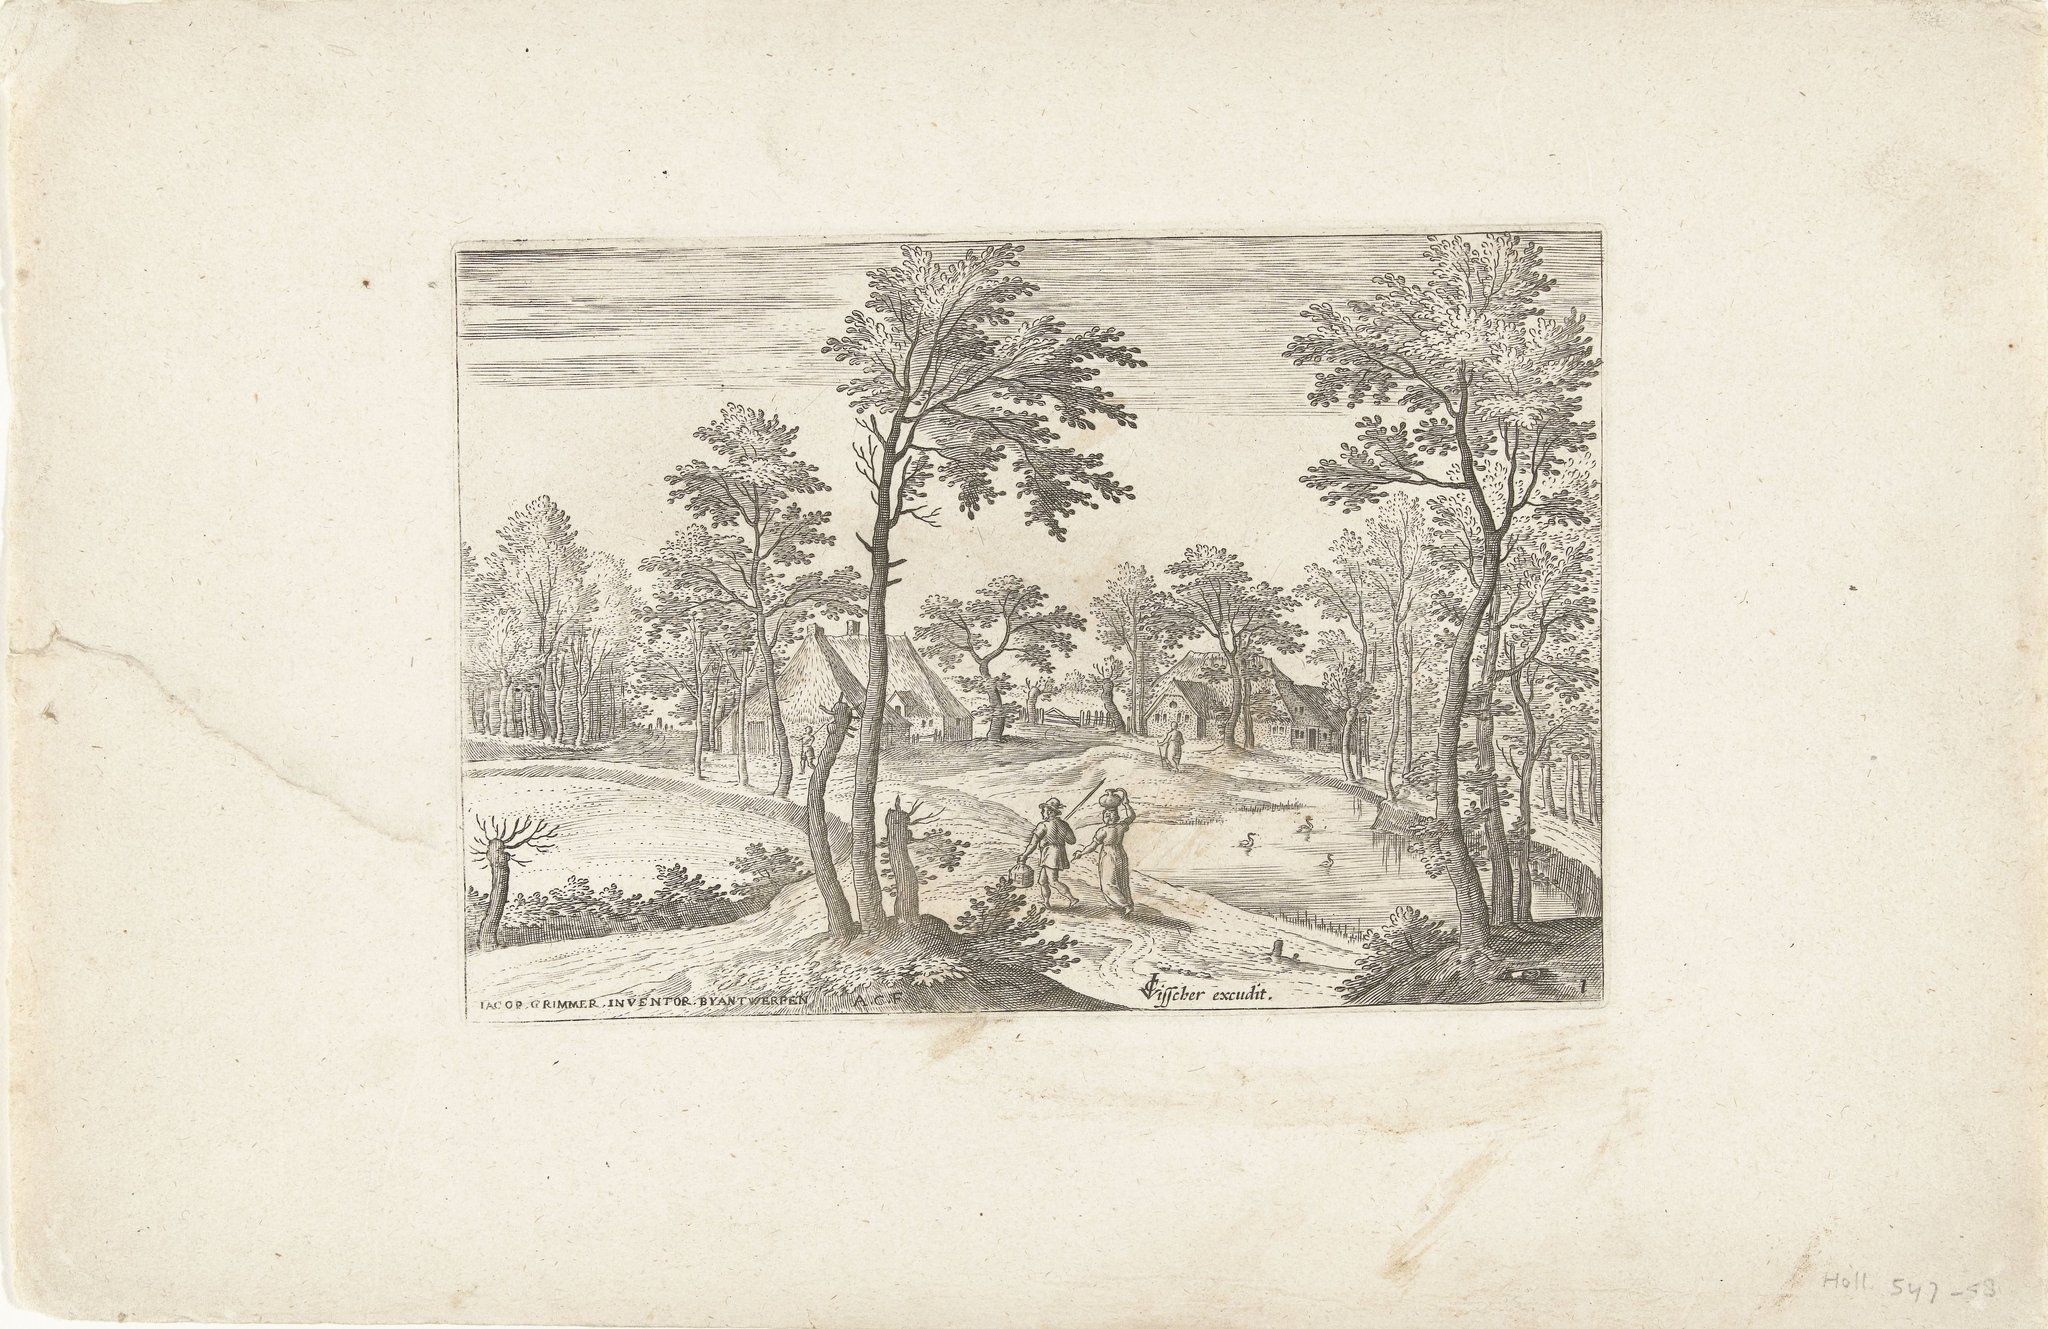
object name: print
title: Landschap met een vijver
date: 1578-1618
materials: paper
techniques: engraving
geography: amsterdam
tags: pond, pool (+ landscape with figures, staffage)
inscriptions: collector's mark: Lugt 2233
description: Landschap met twee wandelaars die op een padje lopen naast een vijver. In de verte twee boerenhoeves. De prent is deel van een twaalfdelige serie met landschappen rond Antwerpen.